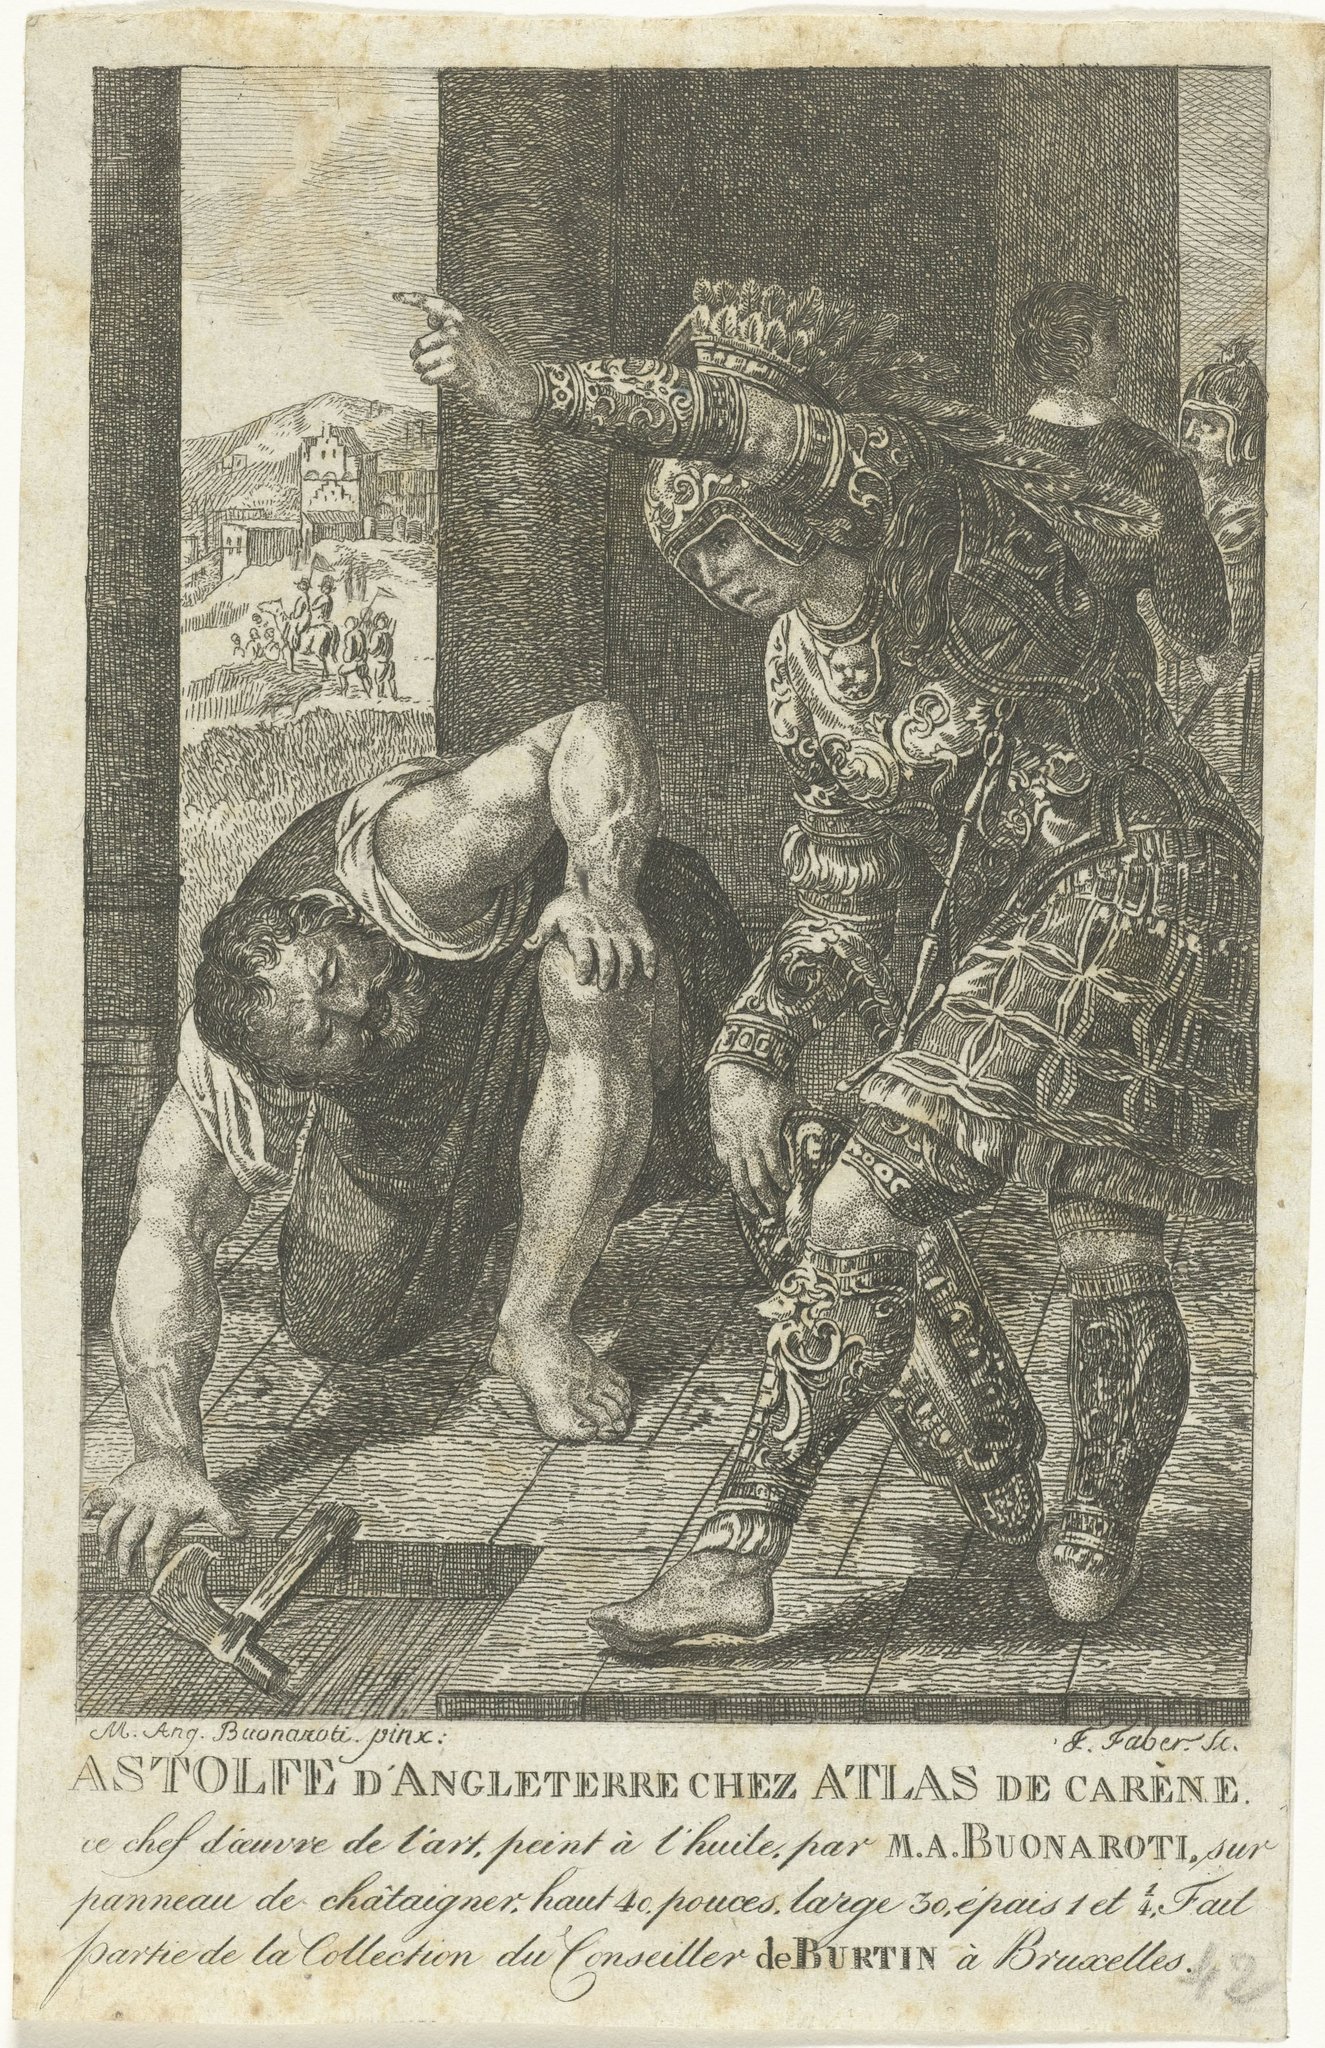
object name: print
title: Wijzende man in harnas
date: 1808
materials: paper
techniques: etching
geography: brussels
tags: armour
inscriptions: collector's mark: Lugt 2228, collector's mark: Lugt 1485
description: Een soldaat in harnas staat wijzend naast een geknielde man. Tussen hen in ligt een bijl. Onder de voorstelling een Franse tekst van vier regels.